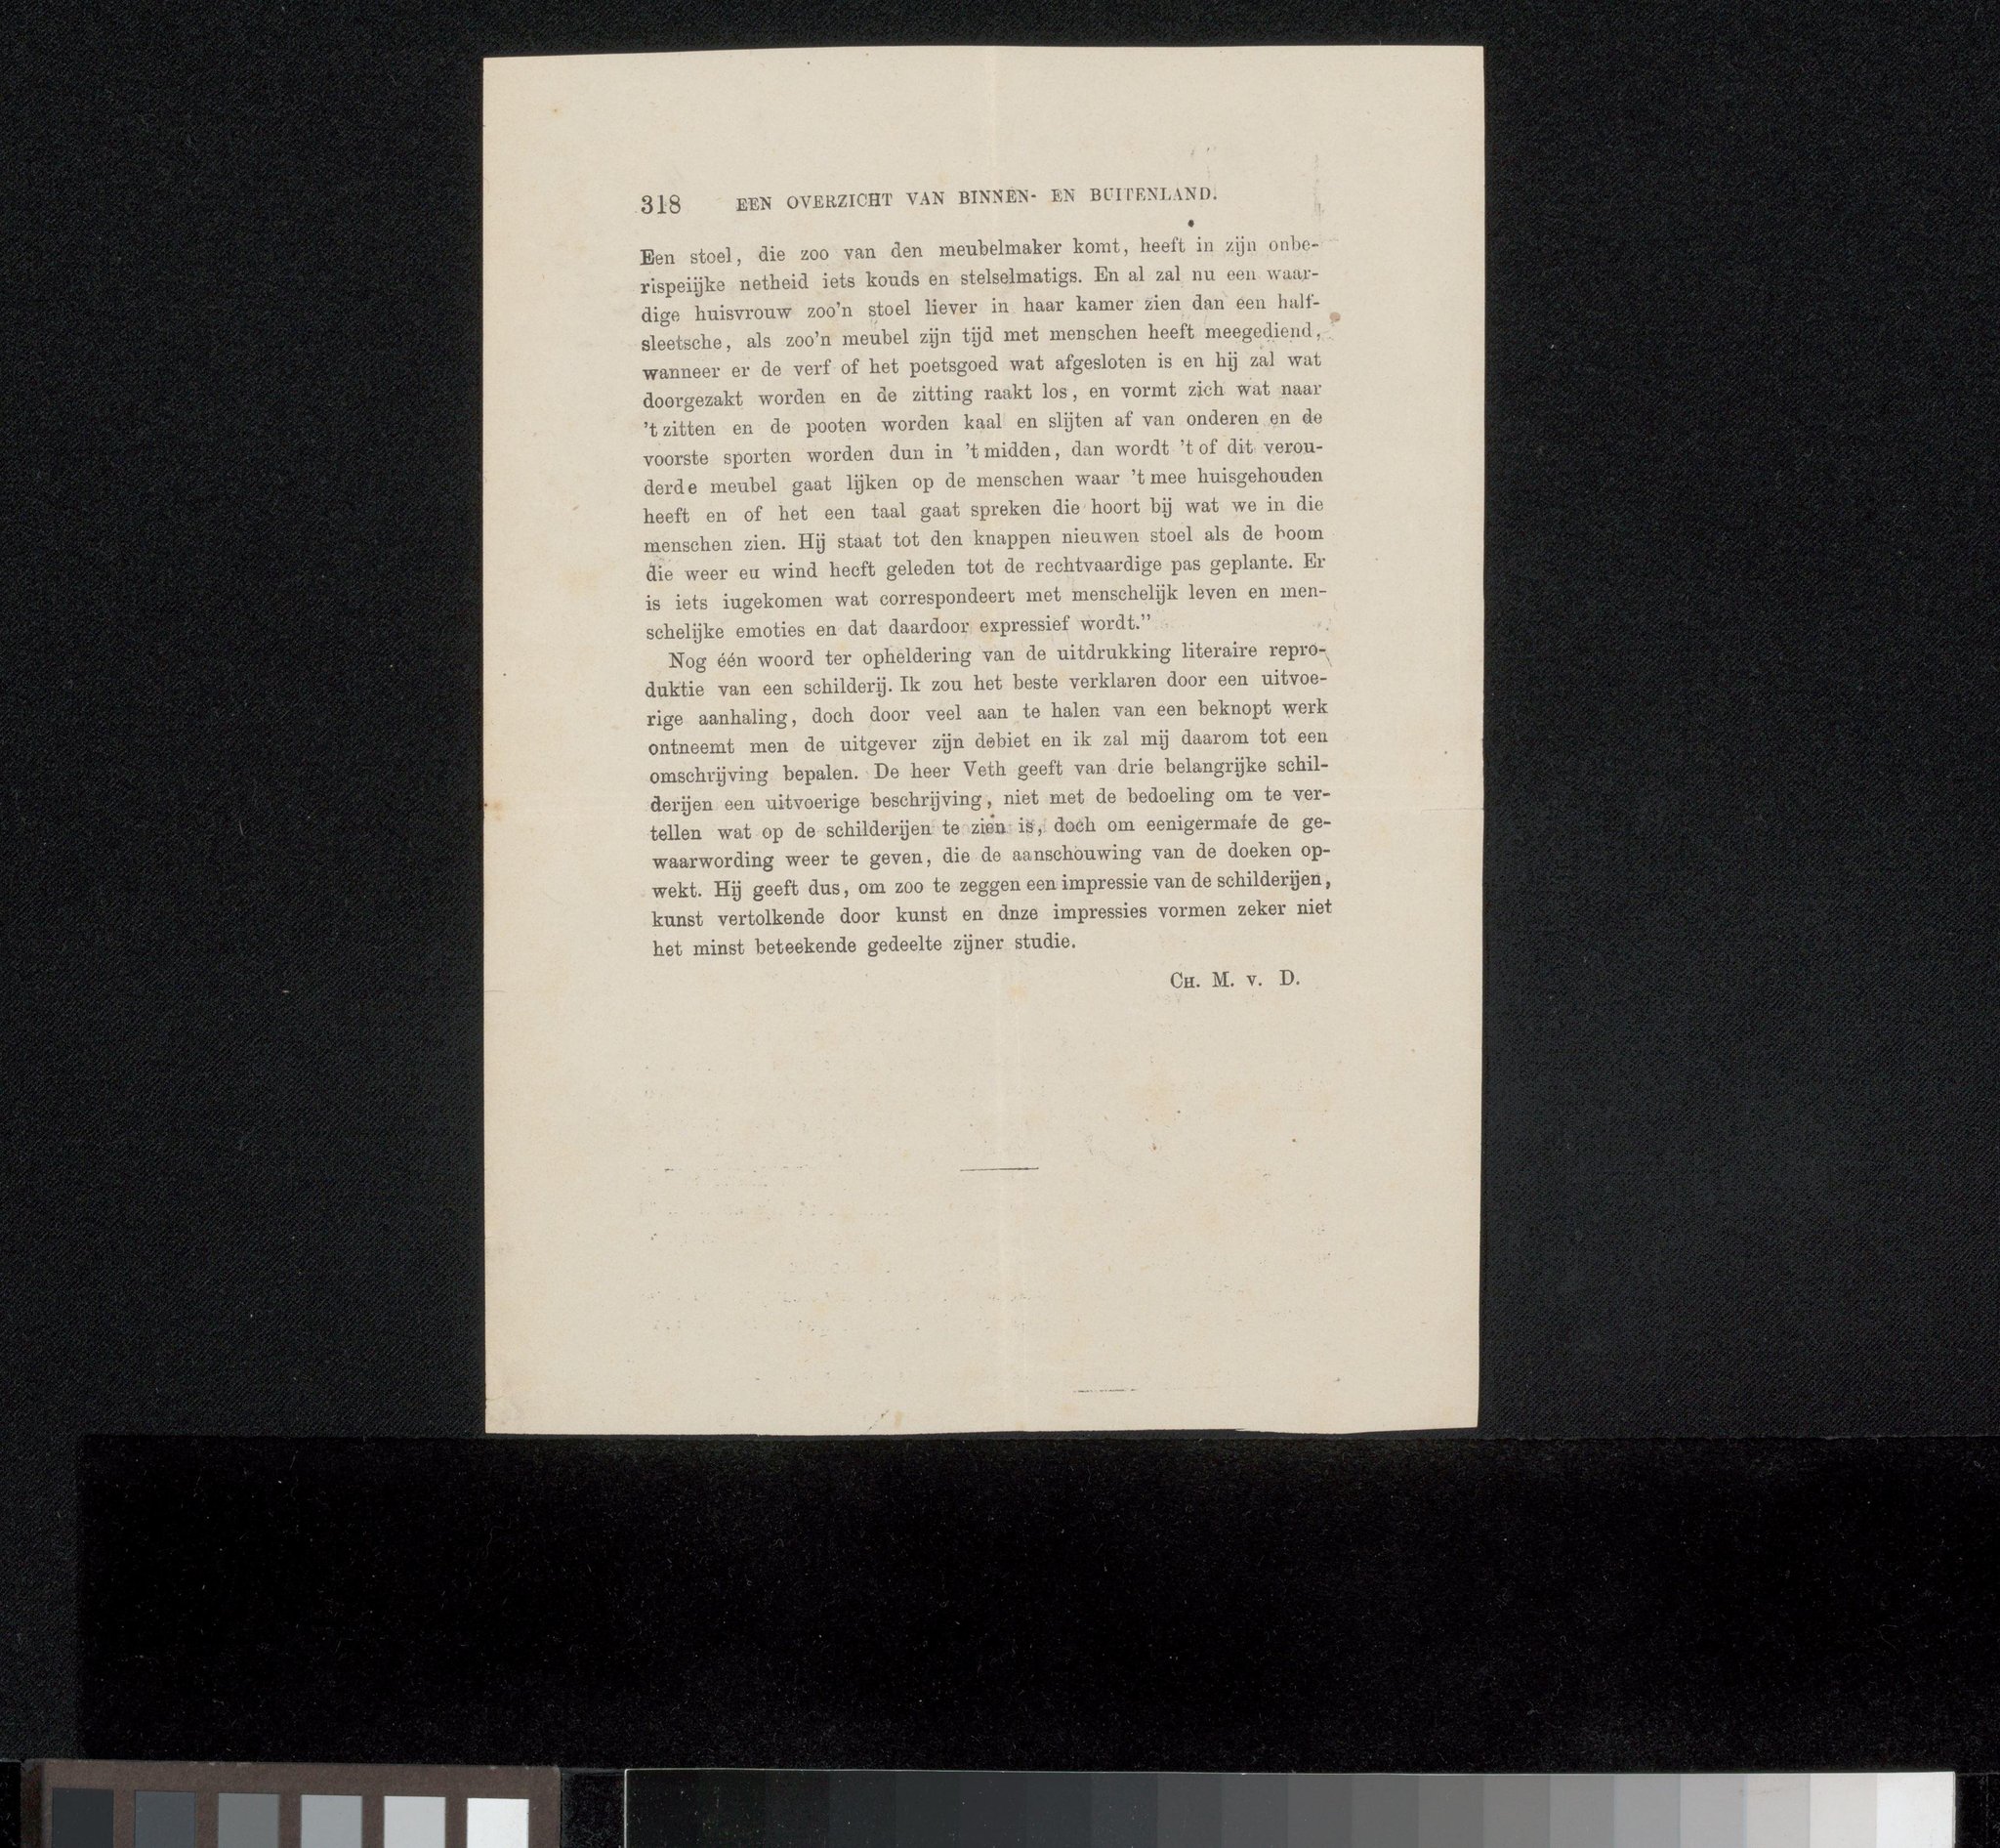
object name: article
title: Artikel uit archief Jan Veth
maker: chap van deventer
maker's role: kunstcriticus, scheikundige, schrijver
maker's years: 1860-1931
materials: paper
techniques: printing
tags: painter, print maker, draughtsman, jozef israëls, jan veth, criticizing and discussing art, art criticism, painting (including book-illumination, miniature-painting)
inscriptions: collector's mark: ‘RPK’